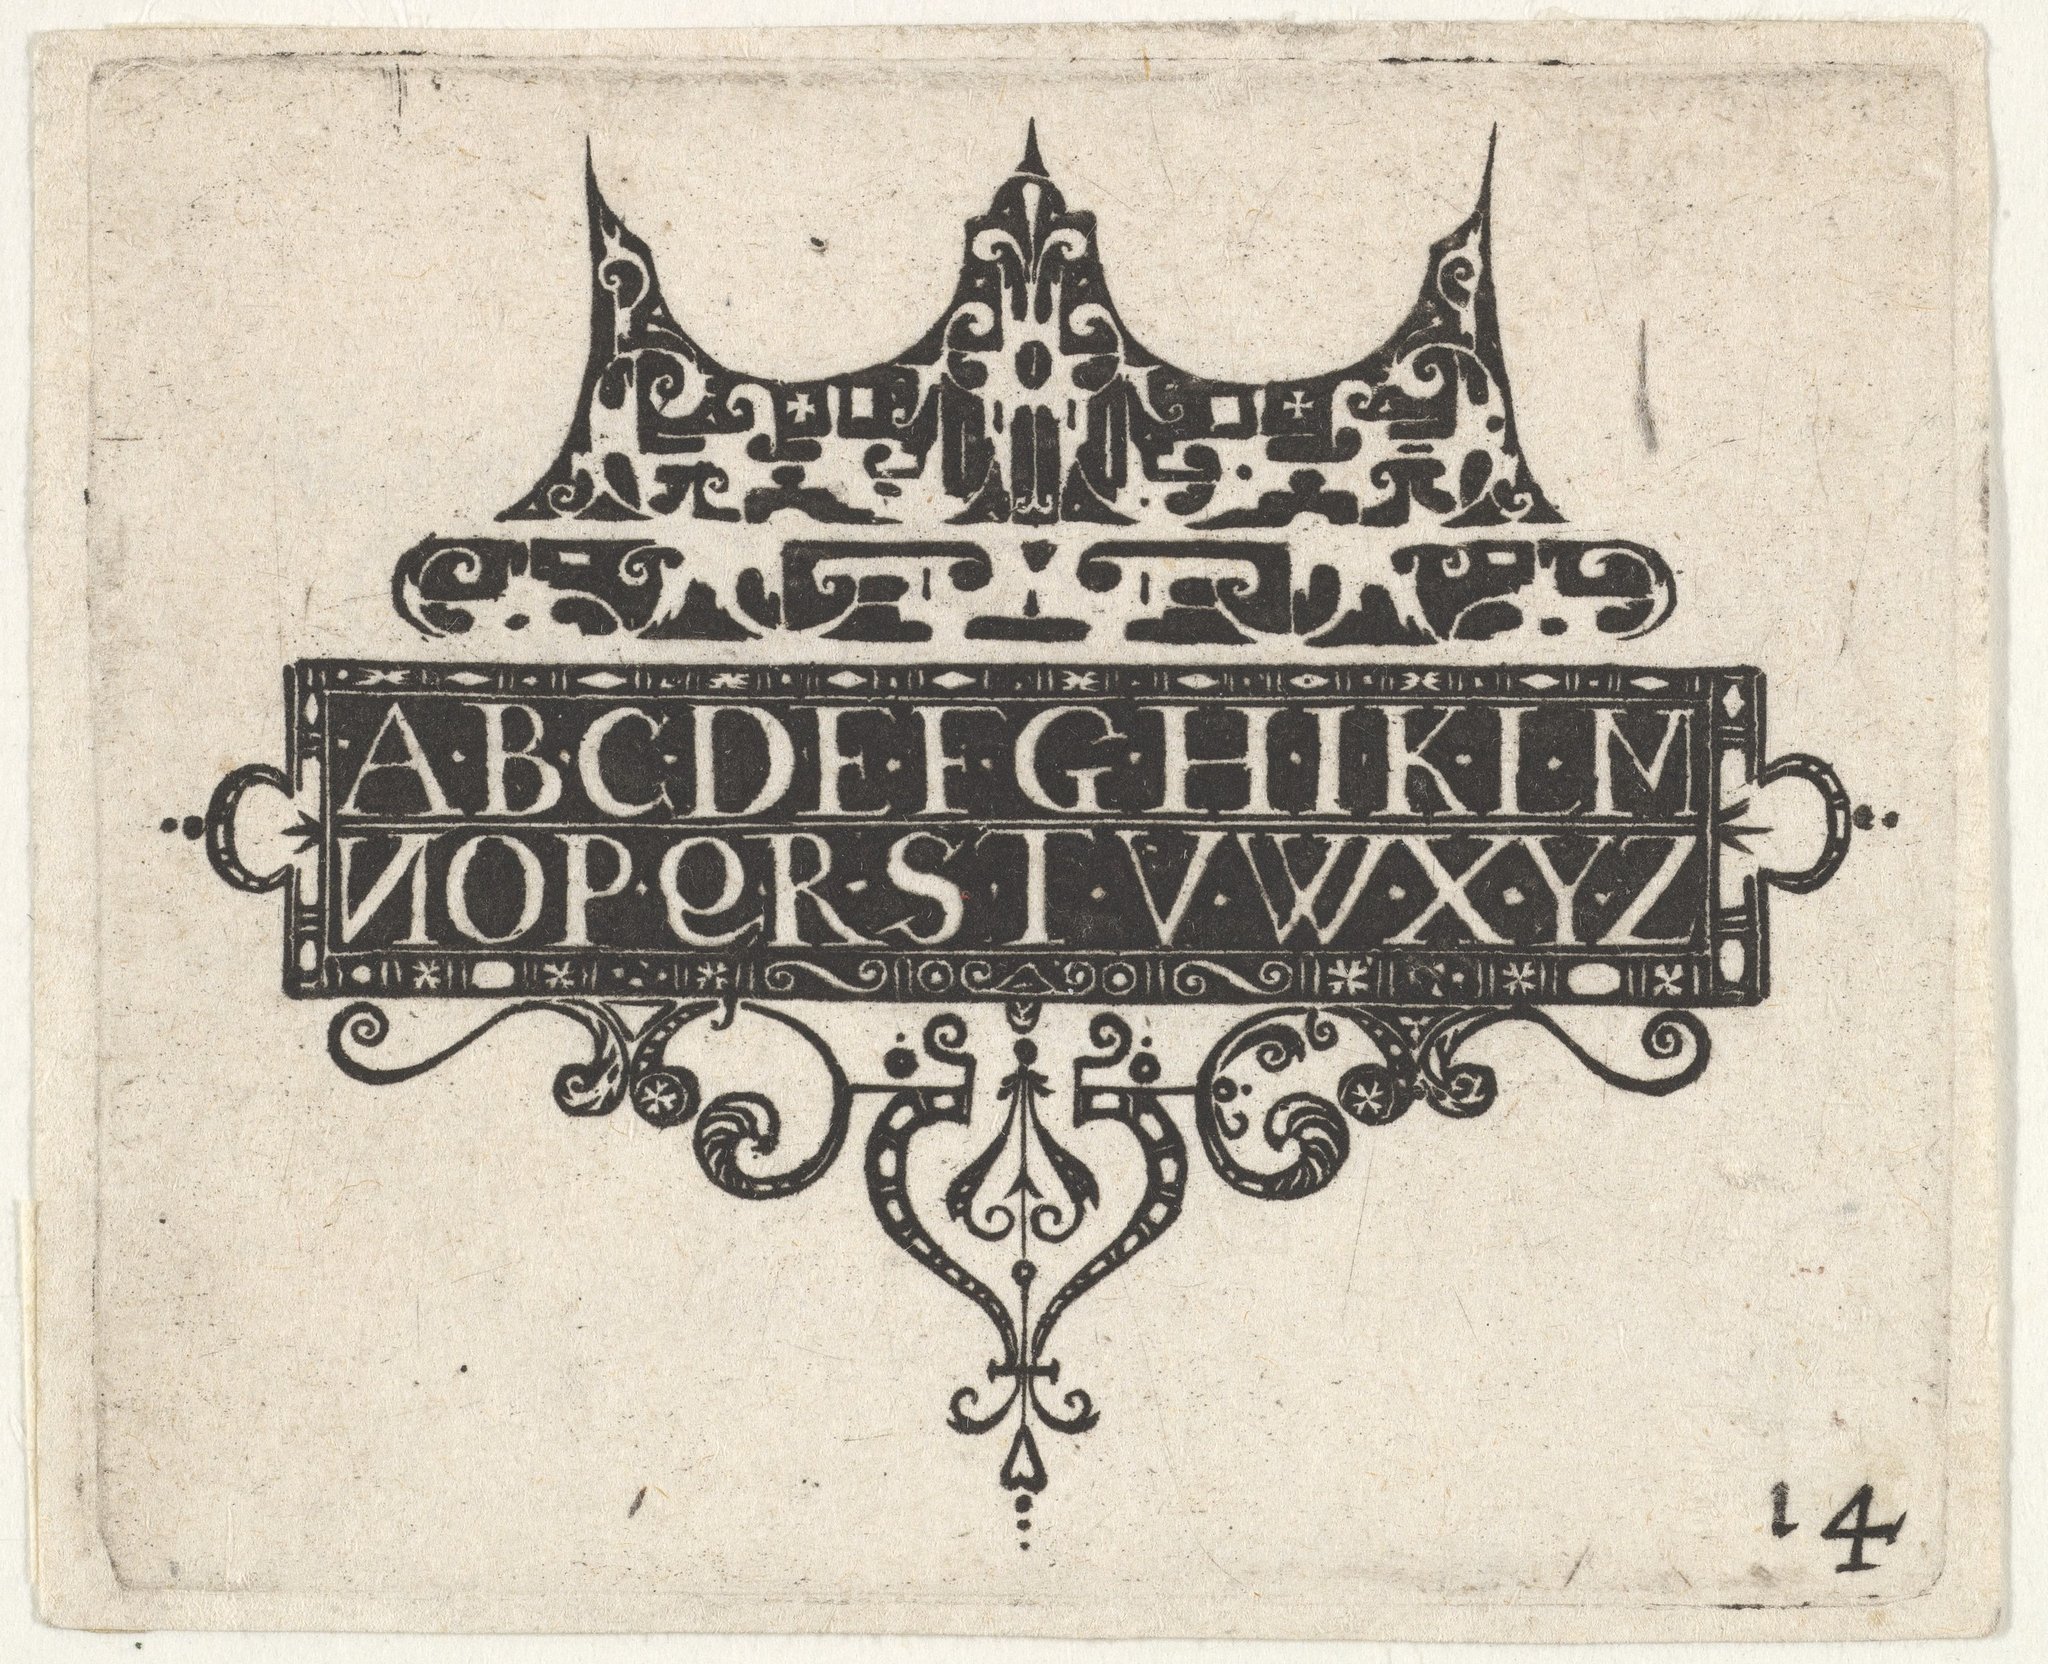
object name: print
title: Blackwork Print with the Alphabet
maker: claes jansz. visscher (ii)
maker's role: artist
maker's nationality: dutch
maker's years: 1586-1652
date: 1620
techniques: embroidery